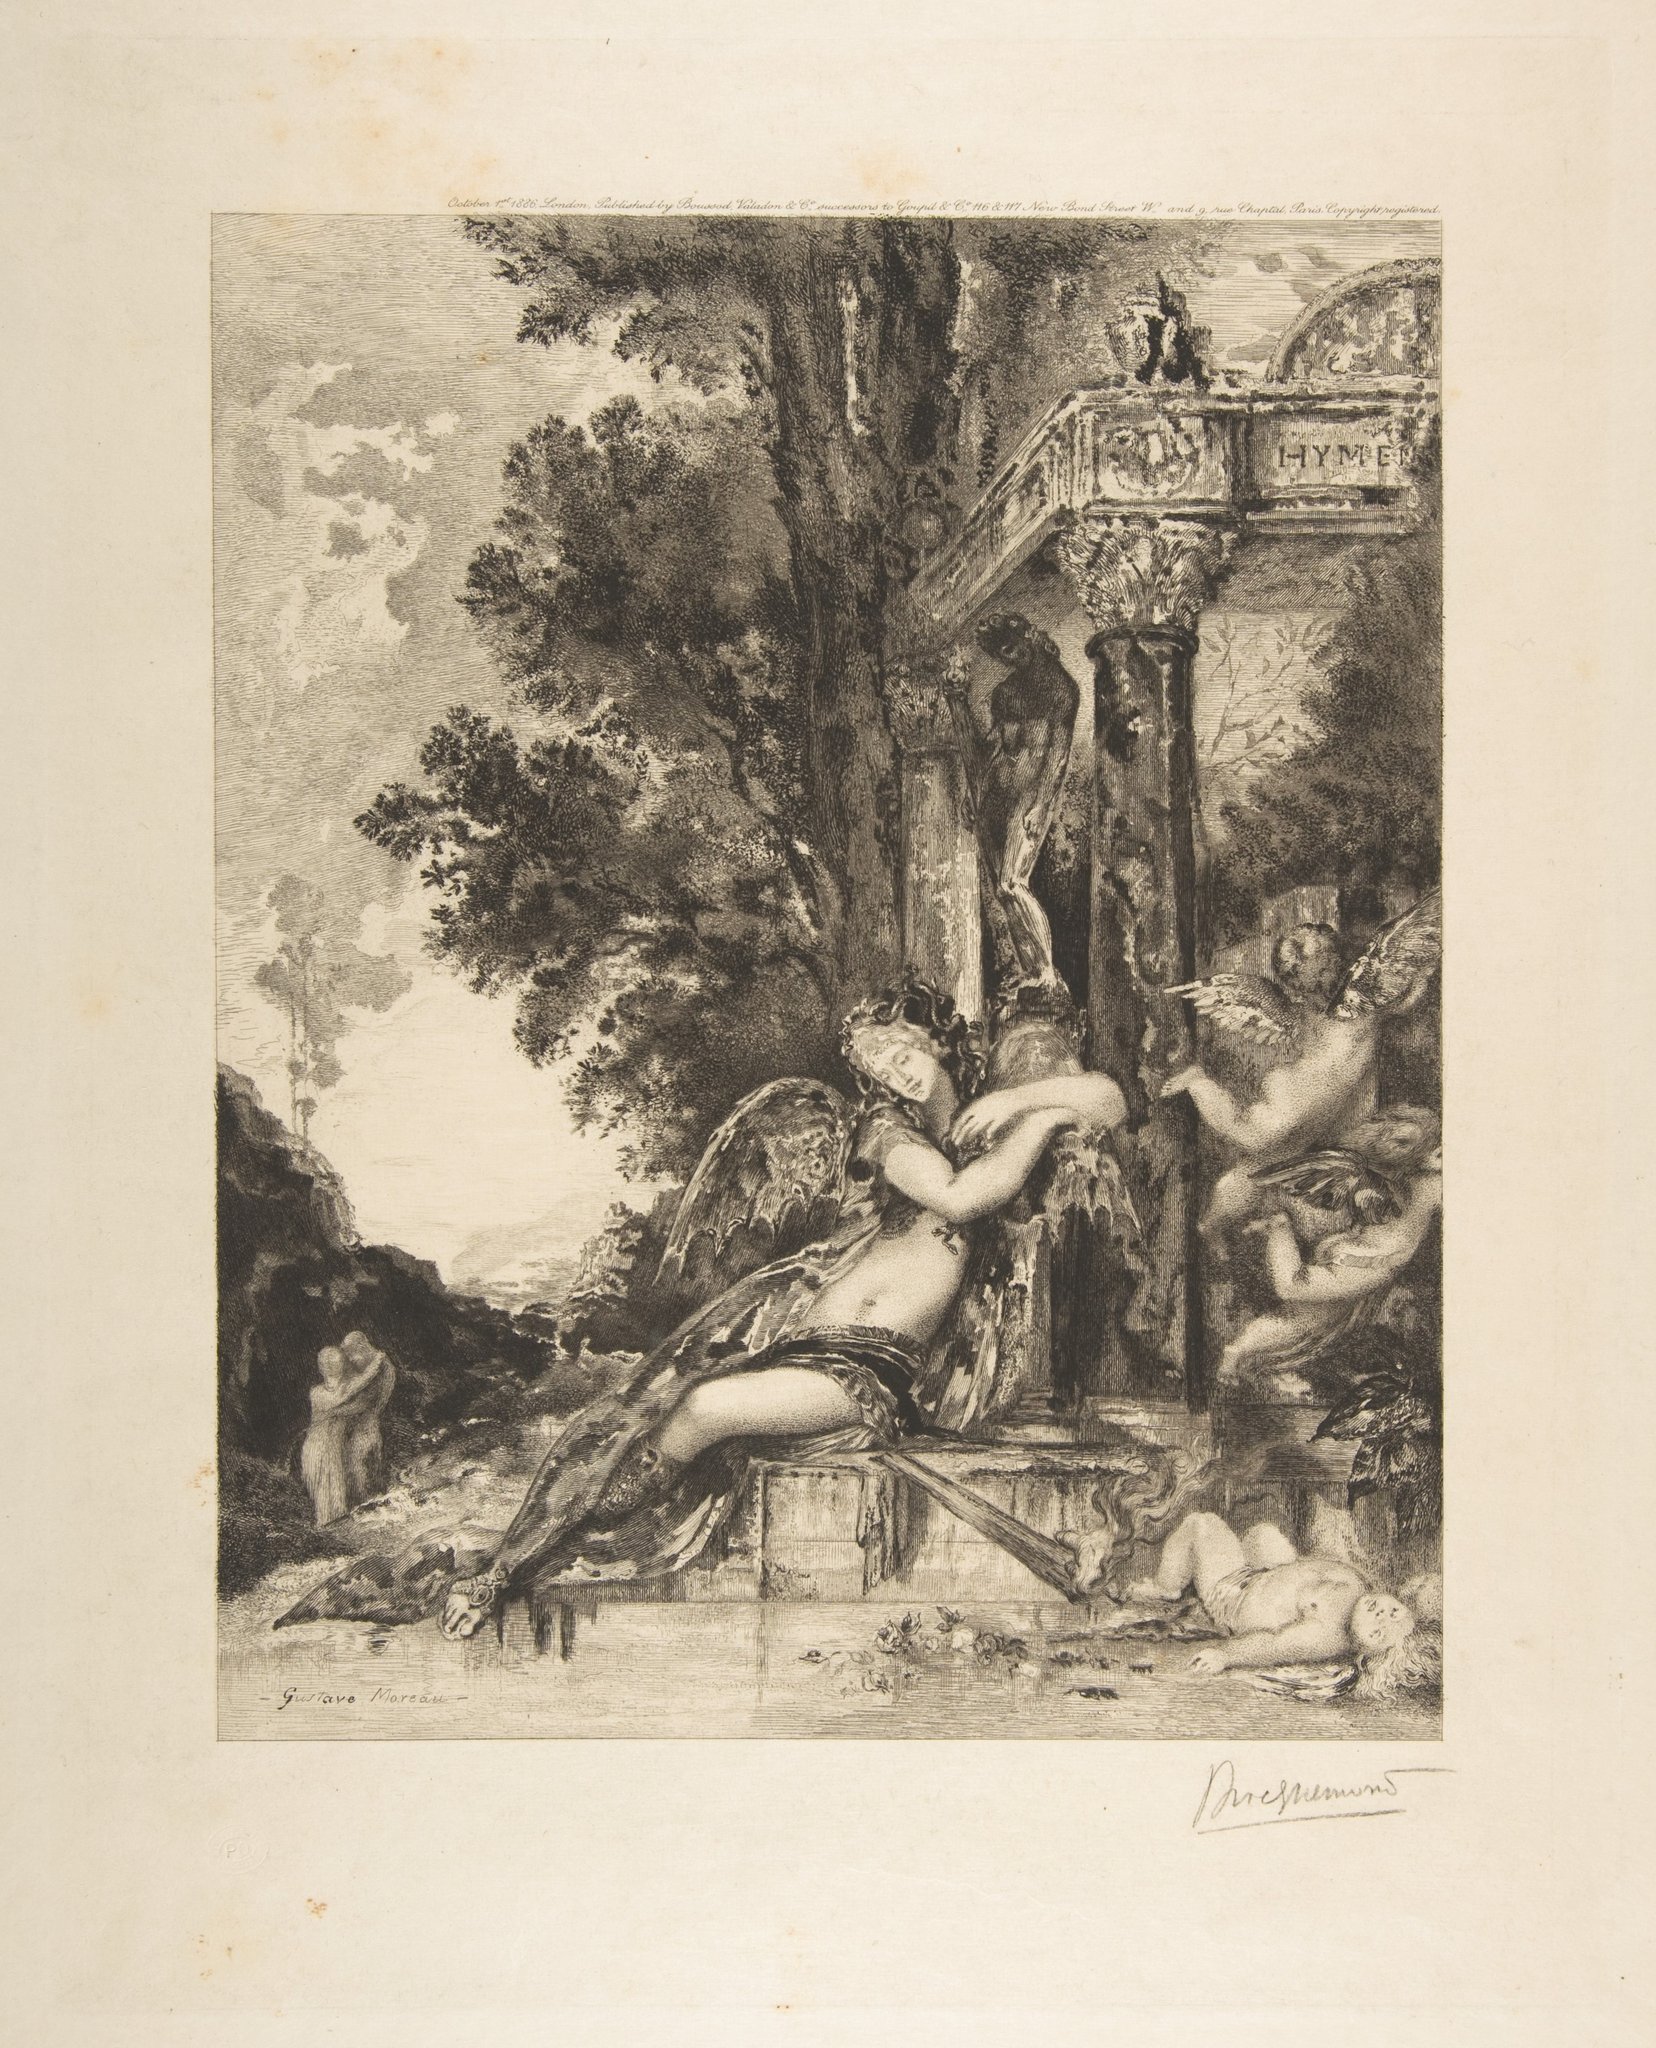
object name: print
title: La Discorde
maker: félix bracquemond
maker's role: artist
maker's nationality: french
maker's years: 1833-1914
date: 1886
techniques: etching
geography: england